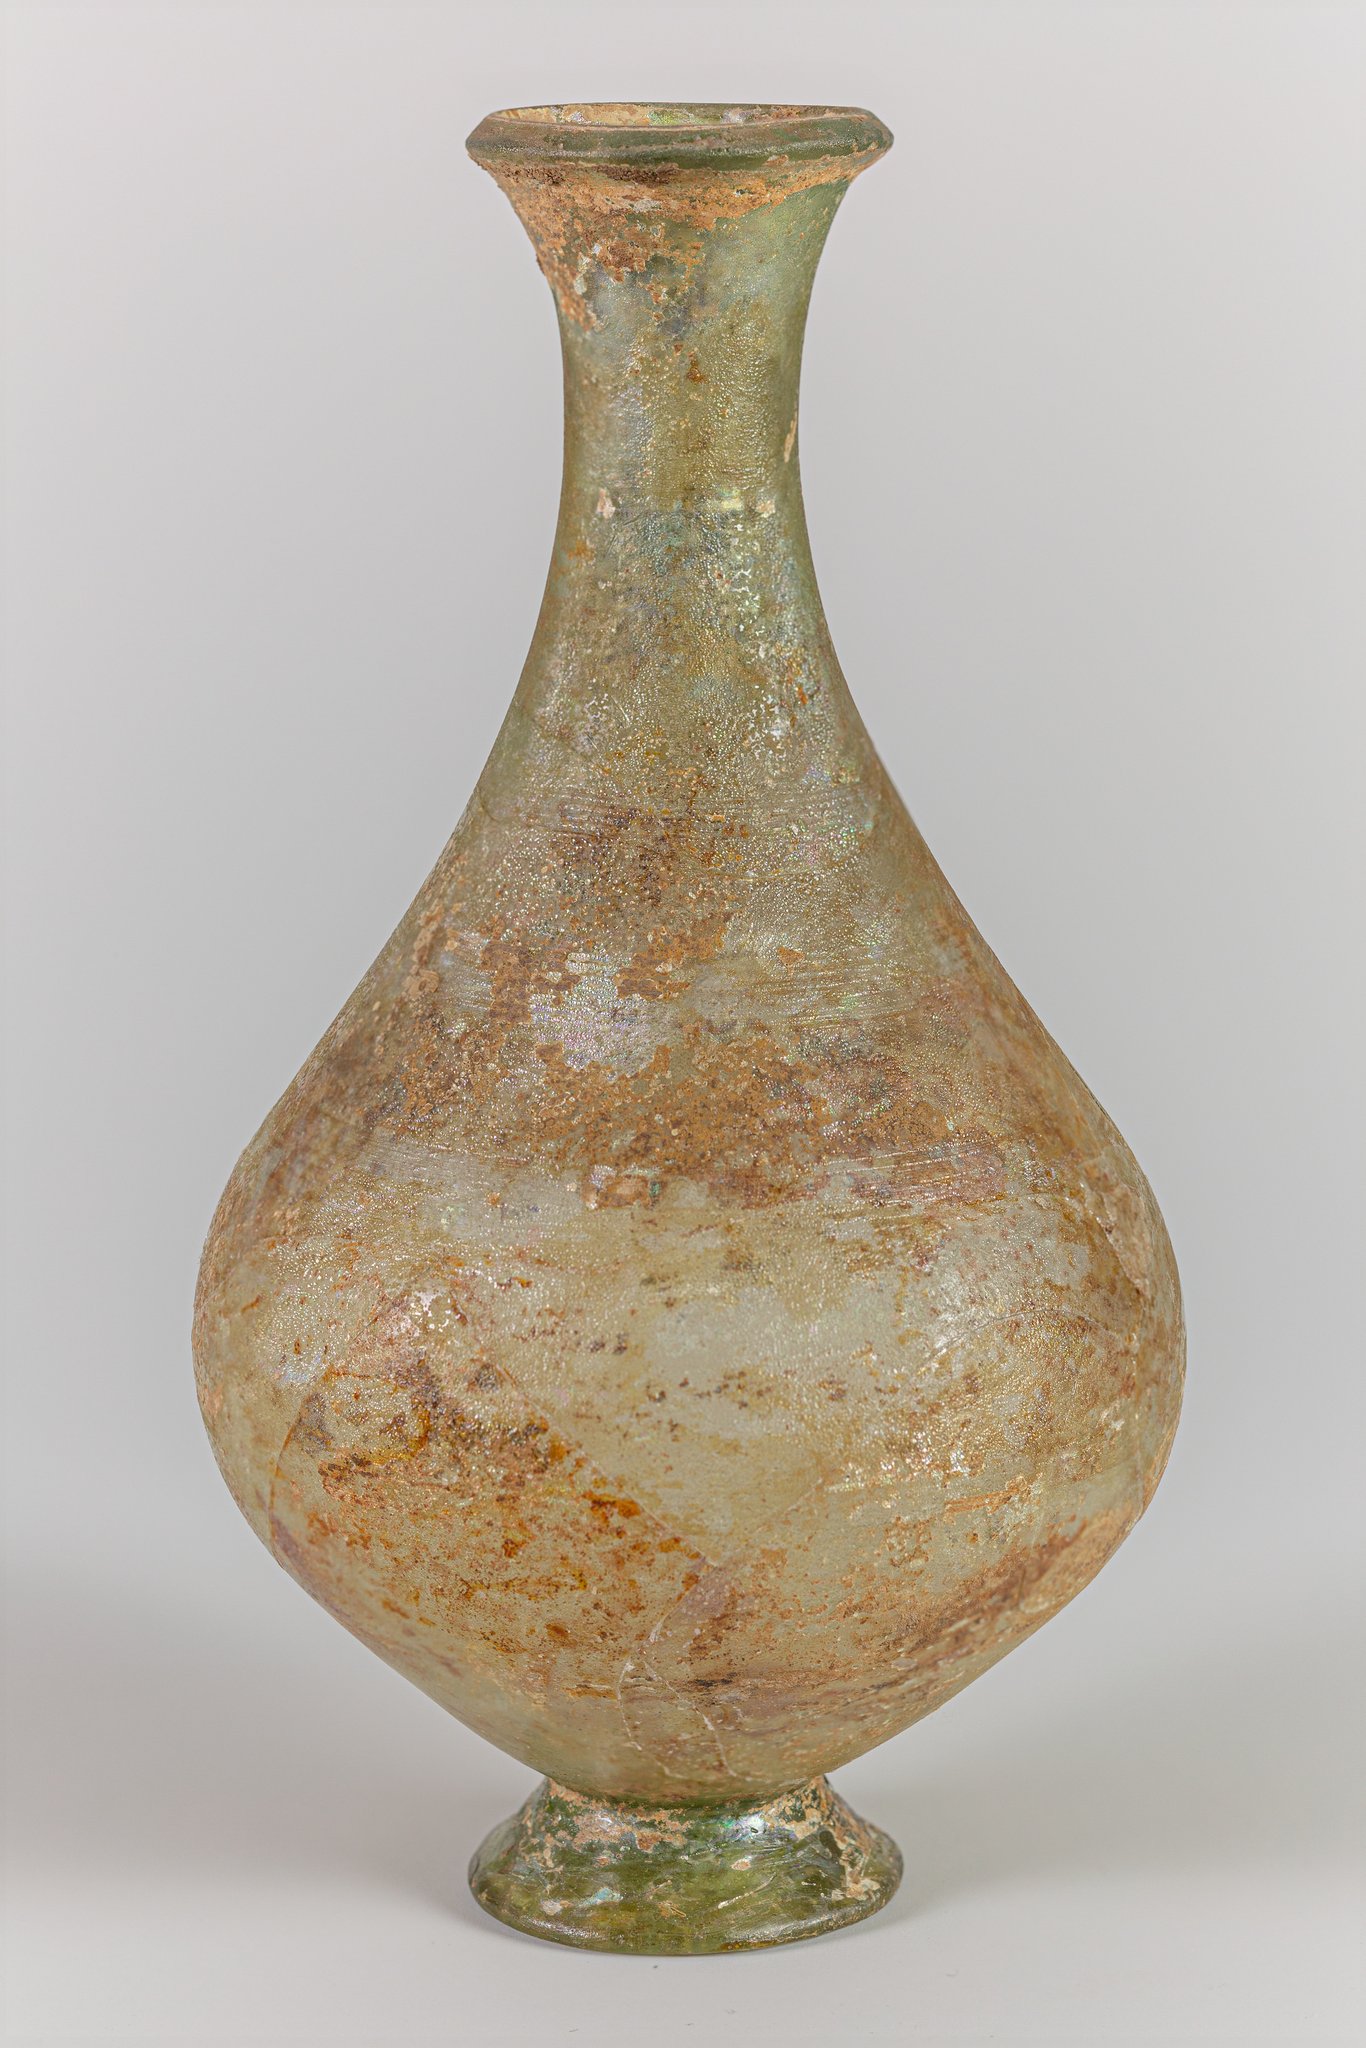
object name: flask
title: Glass flask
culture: roman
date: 201-400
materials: glass